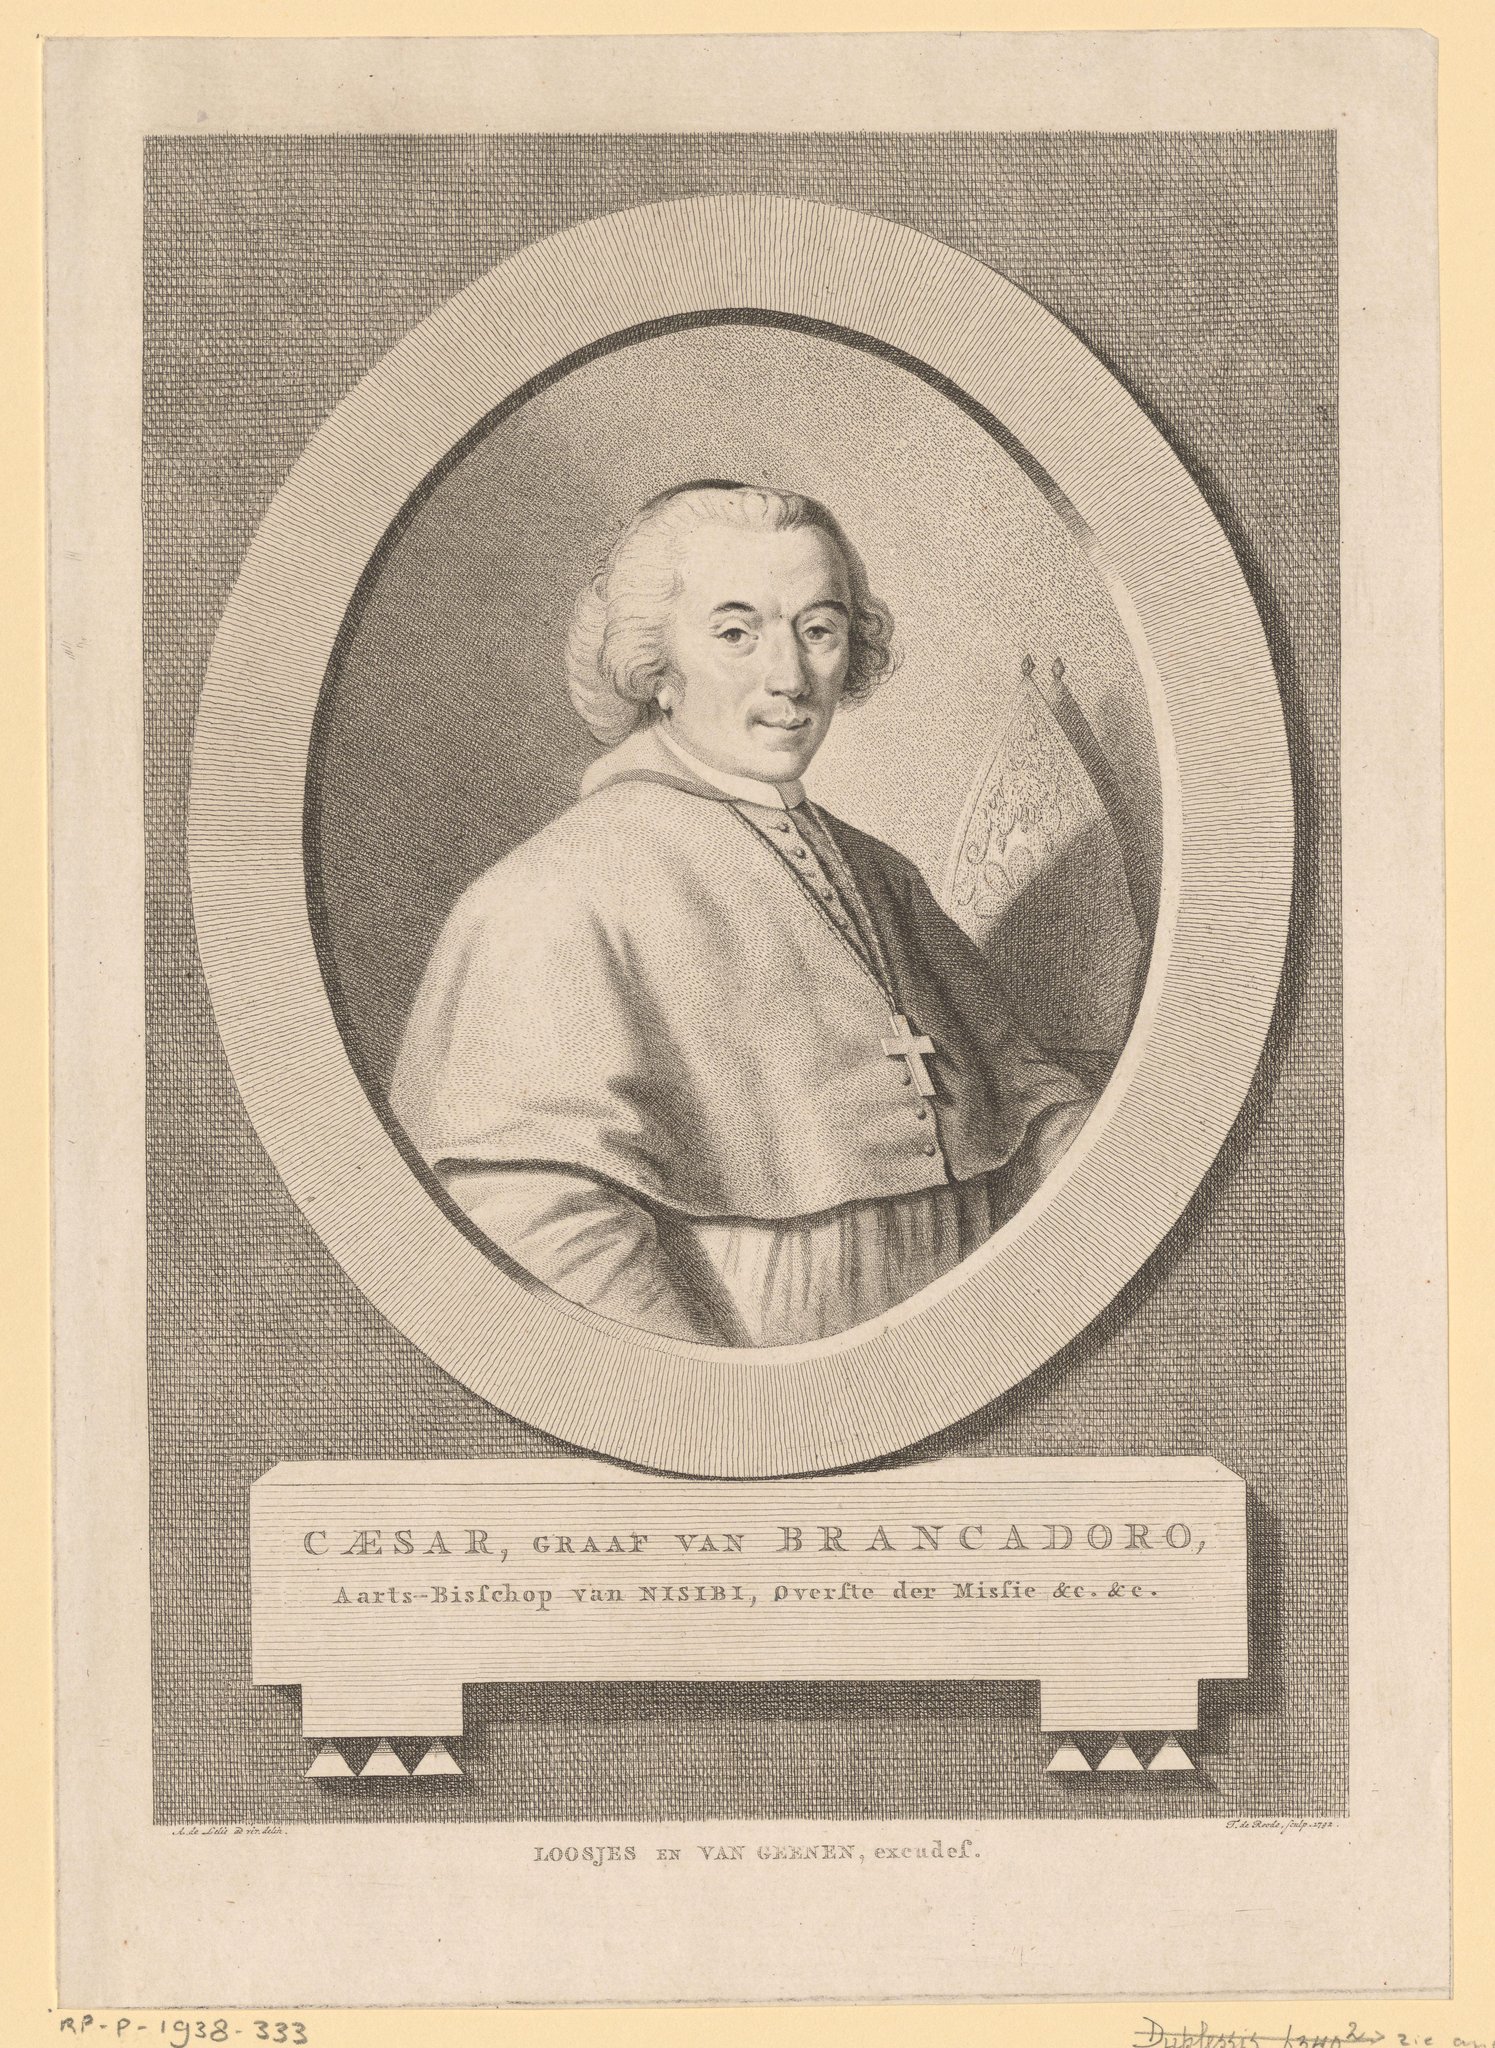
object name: print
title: Portret van Cesare Brancadoro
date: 1792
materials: paper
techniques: etching, roulette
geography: haarlem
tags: rome, cardinal, historical persons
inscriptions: collector's mark: Lugt 2228